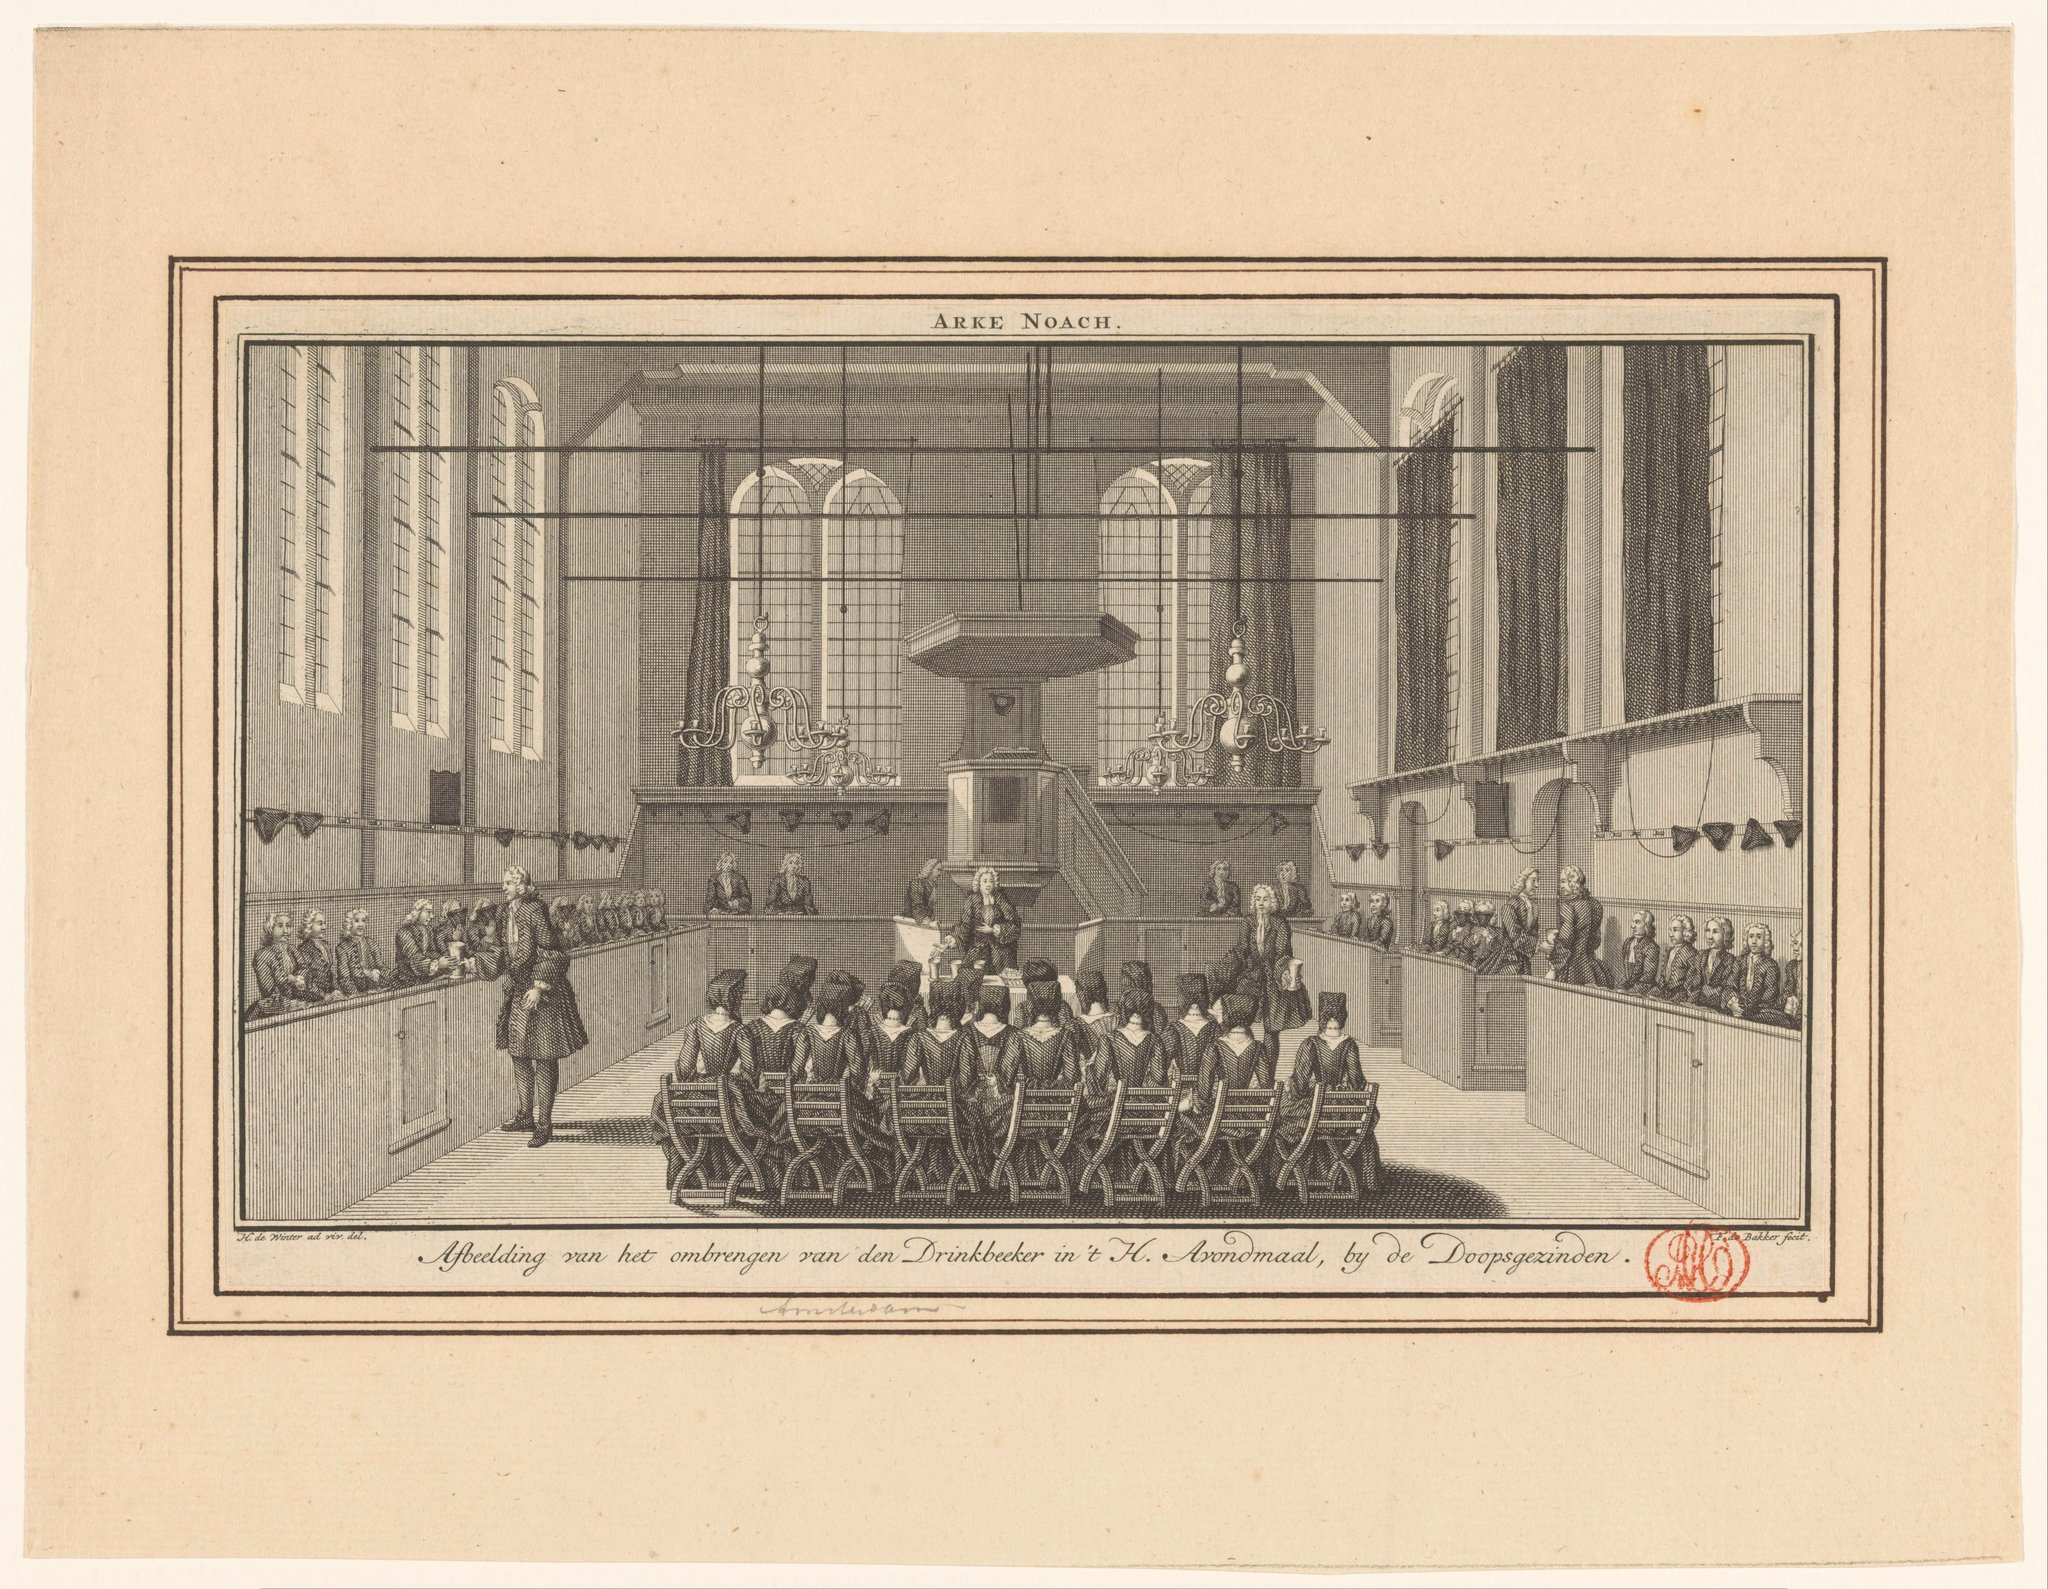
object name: print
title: Arke Noach / Afbeelding van het ombrengen van den Drinkbeeker in 't H. Avondmaal, by de Doopsgezinden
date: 1743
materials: paper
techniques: engraving, etching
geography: amsterdam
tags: protestant churches and denominations (mennonites), interior of church, holy communion ~ protestant service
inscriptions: collector's mark: Lugt 195, collector's mark: Lugt 2233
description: Rondgaan van de drinkbeker tijdens het Heilig Avondmaal in de Doopsgezinde Kerk De Arke Noach, de vermaning van de Oude Friezen, aan de Prinsengracht te Amsterdam.